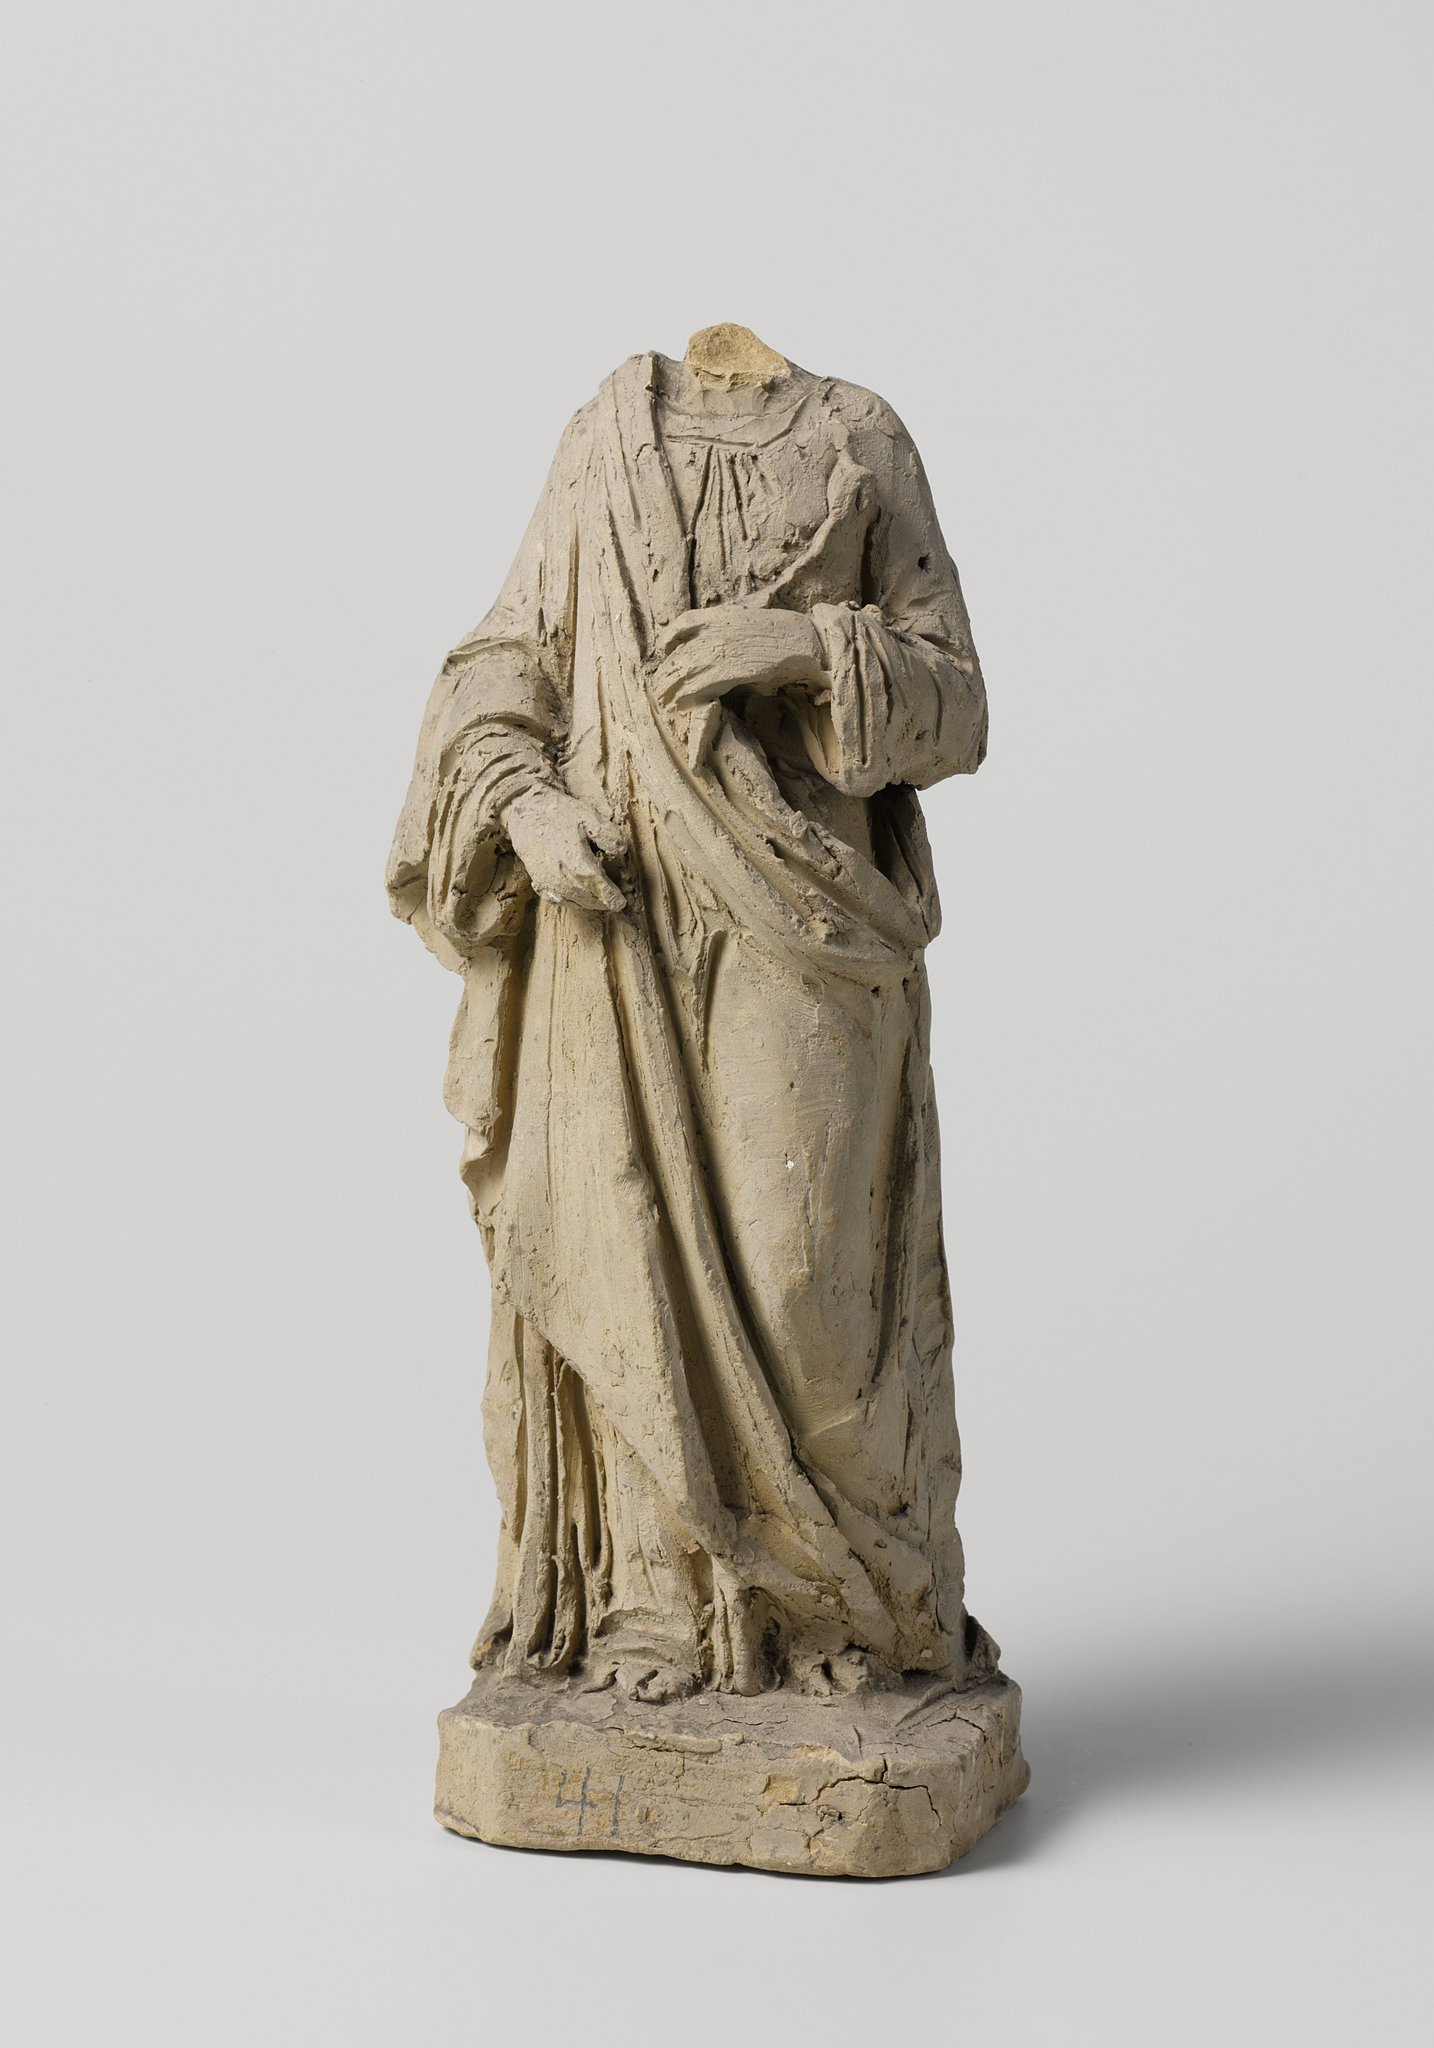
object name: sculpture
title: Bijbelse figuur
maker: eugène lacomblé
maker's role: draughtsman, painter, sculptor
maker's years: 1828-1905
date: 1800-1900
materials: clay